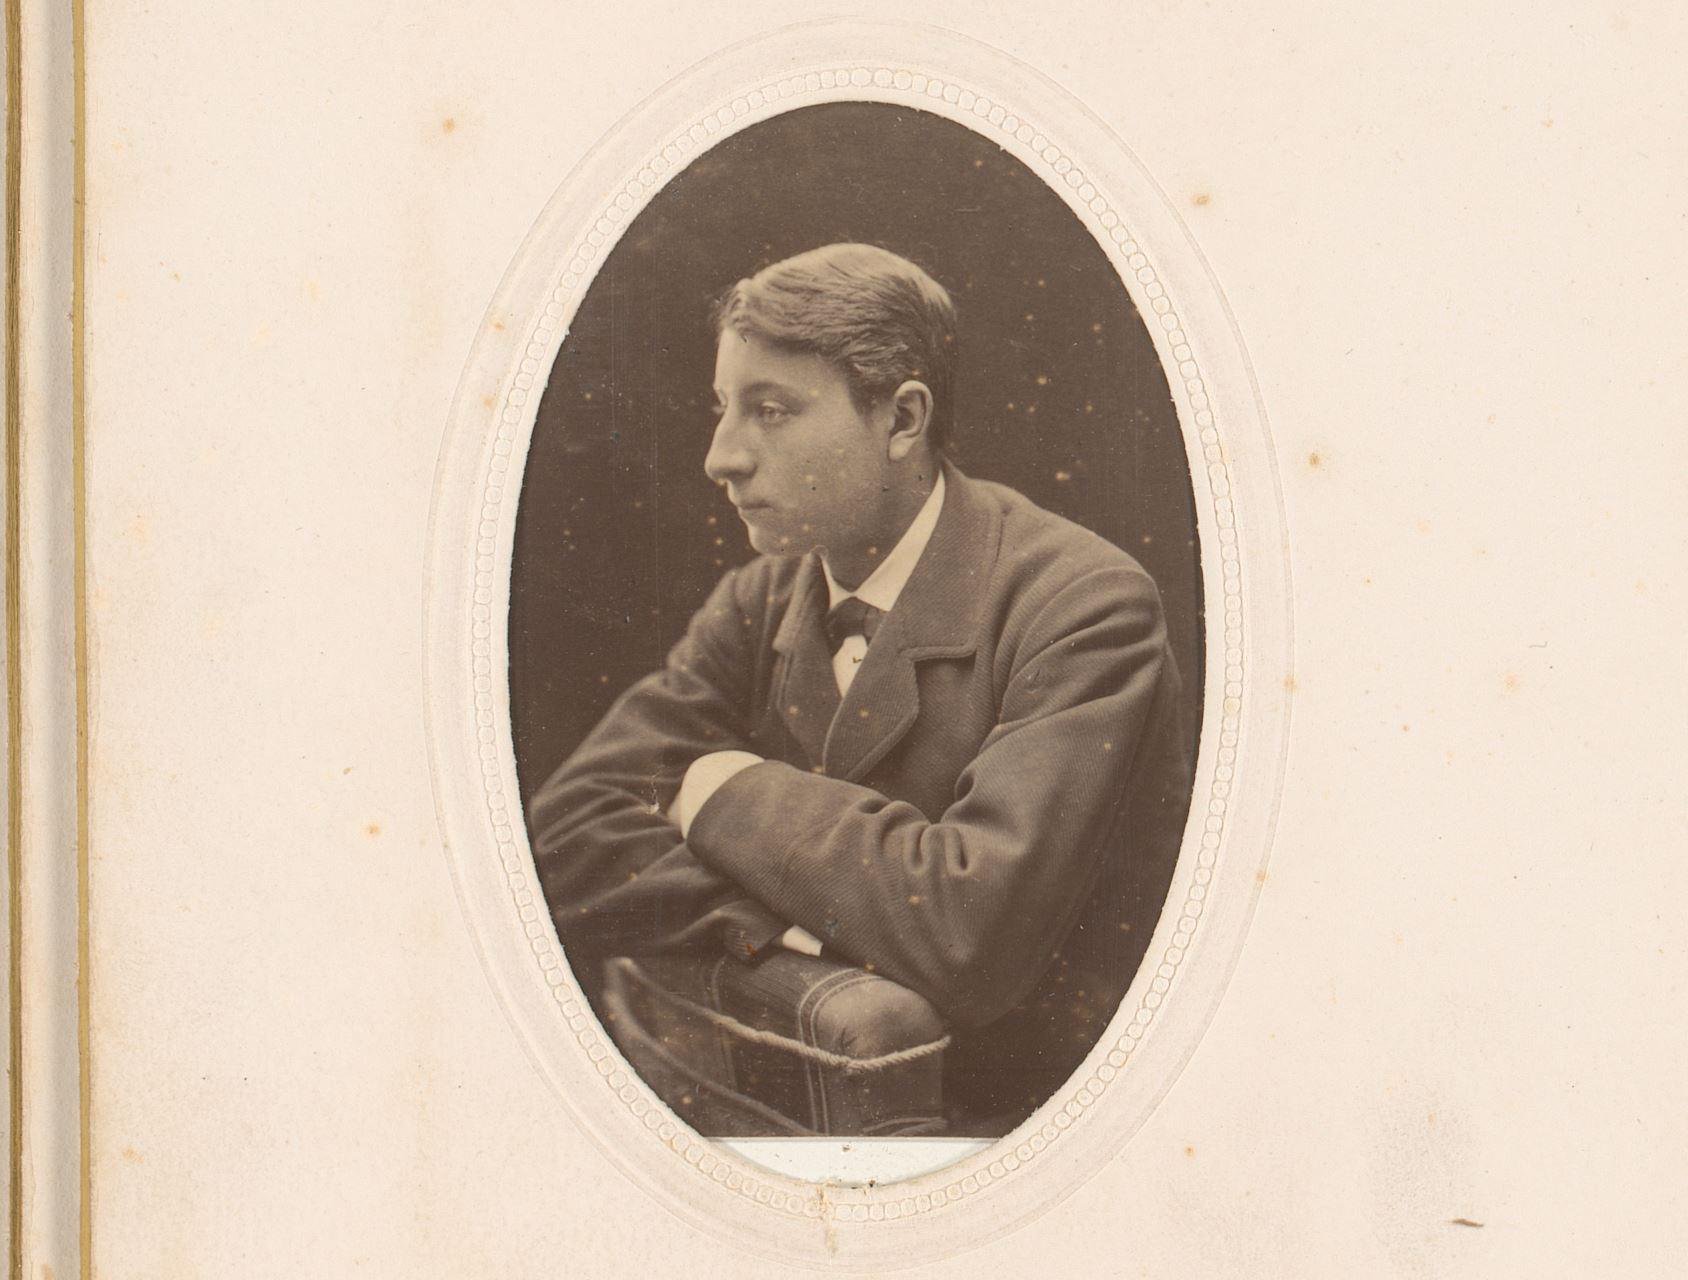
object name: carte de visite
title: Portret van een jonge man, leunend op de leuning van een stoel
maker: albert greiner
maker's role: fotograaf, fotostudio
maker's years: 1833-1890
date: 1878-1887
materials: cardboard, celluloid, photographic support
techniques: albumen print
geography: amsterdam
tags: sitting figure, historical persons, youth, adolescent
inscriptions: inscription: ‘Photograaf/ van/ HH: MM:/ den Koning en/ Koningin der Nederlanden/ Amsterdam/ 1877/ Parijs/ 1878/ A. GREINER/ NIEUWENDIJK ,89/ AMSTERDAM’